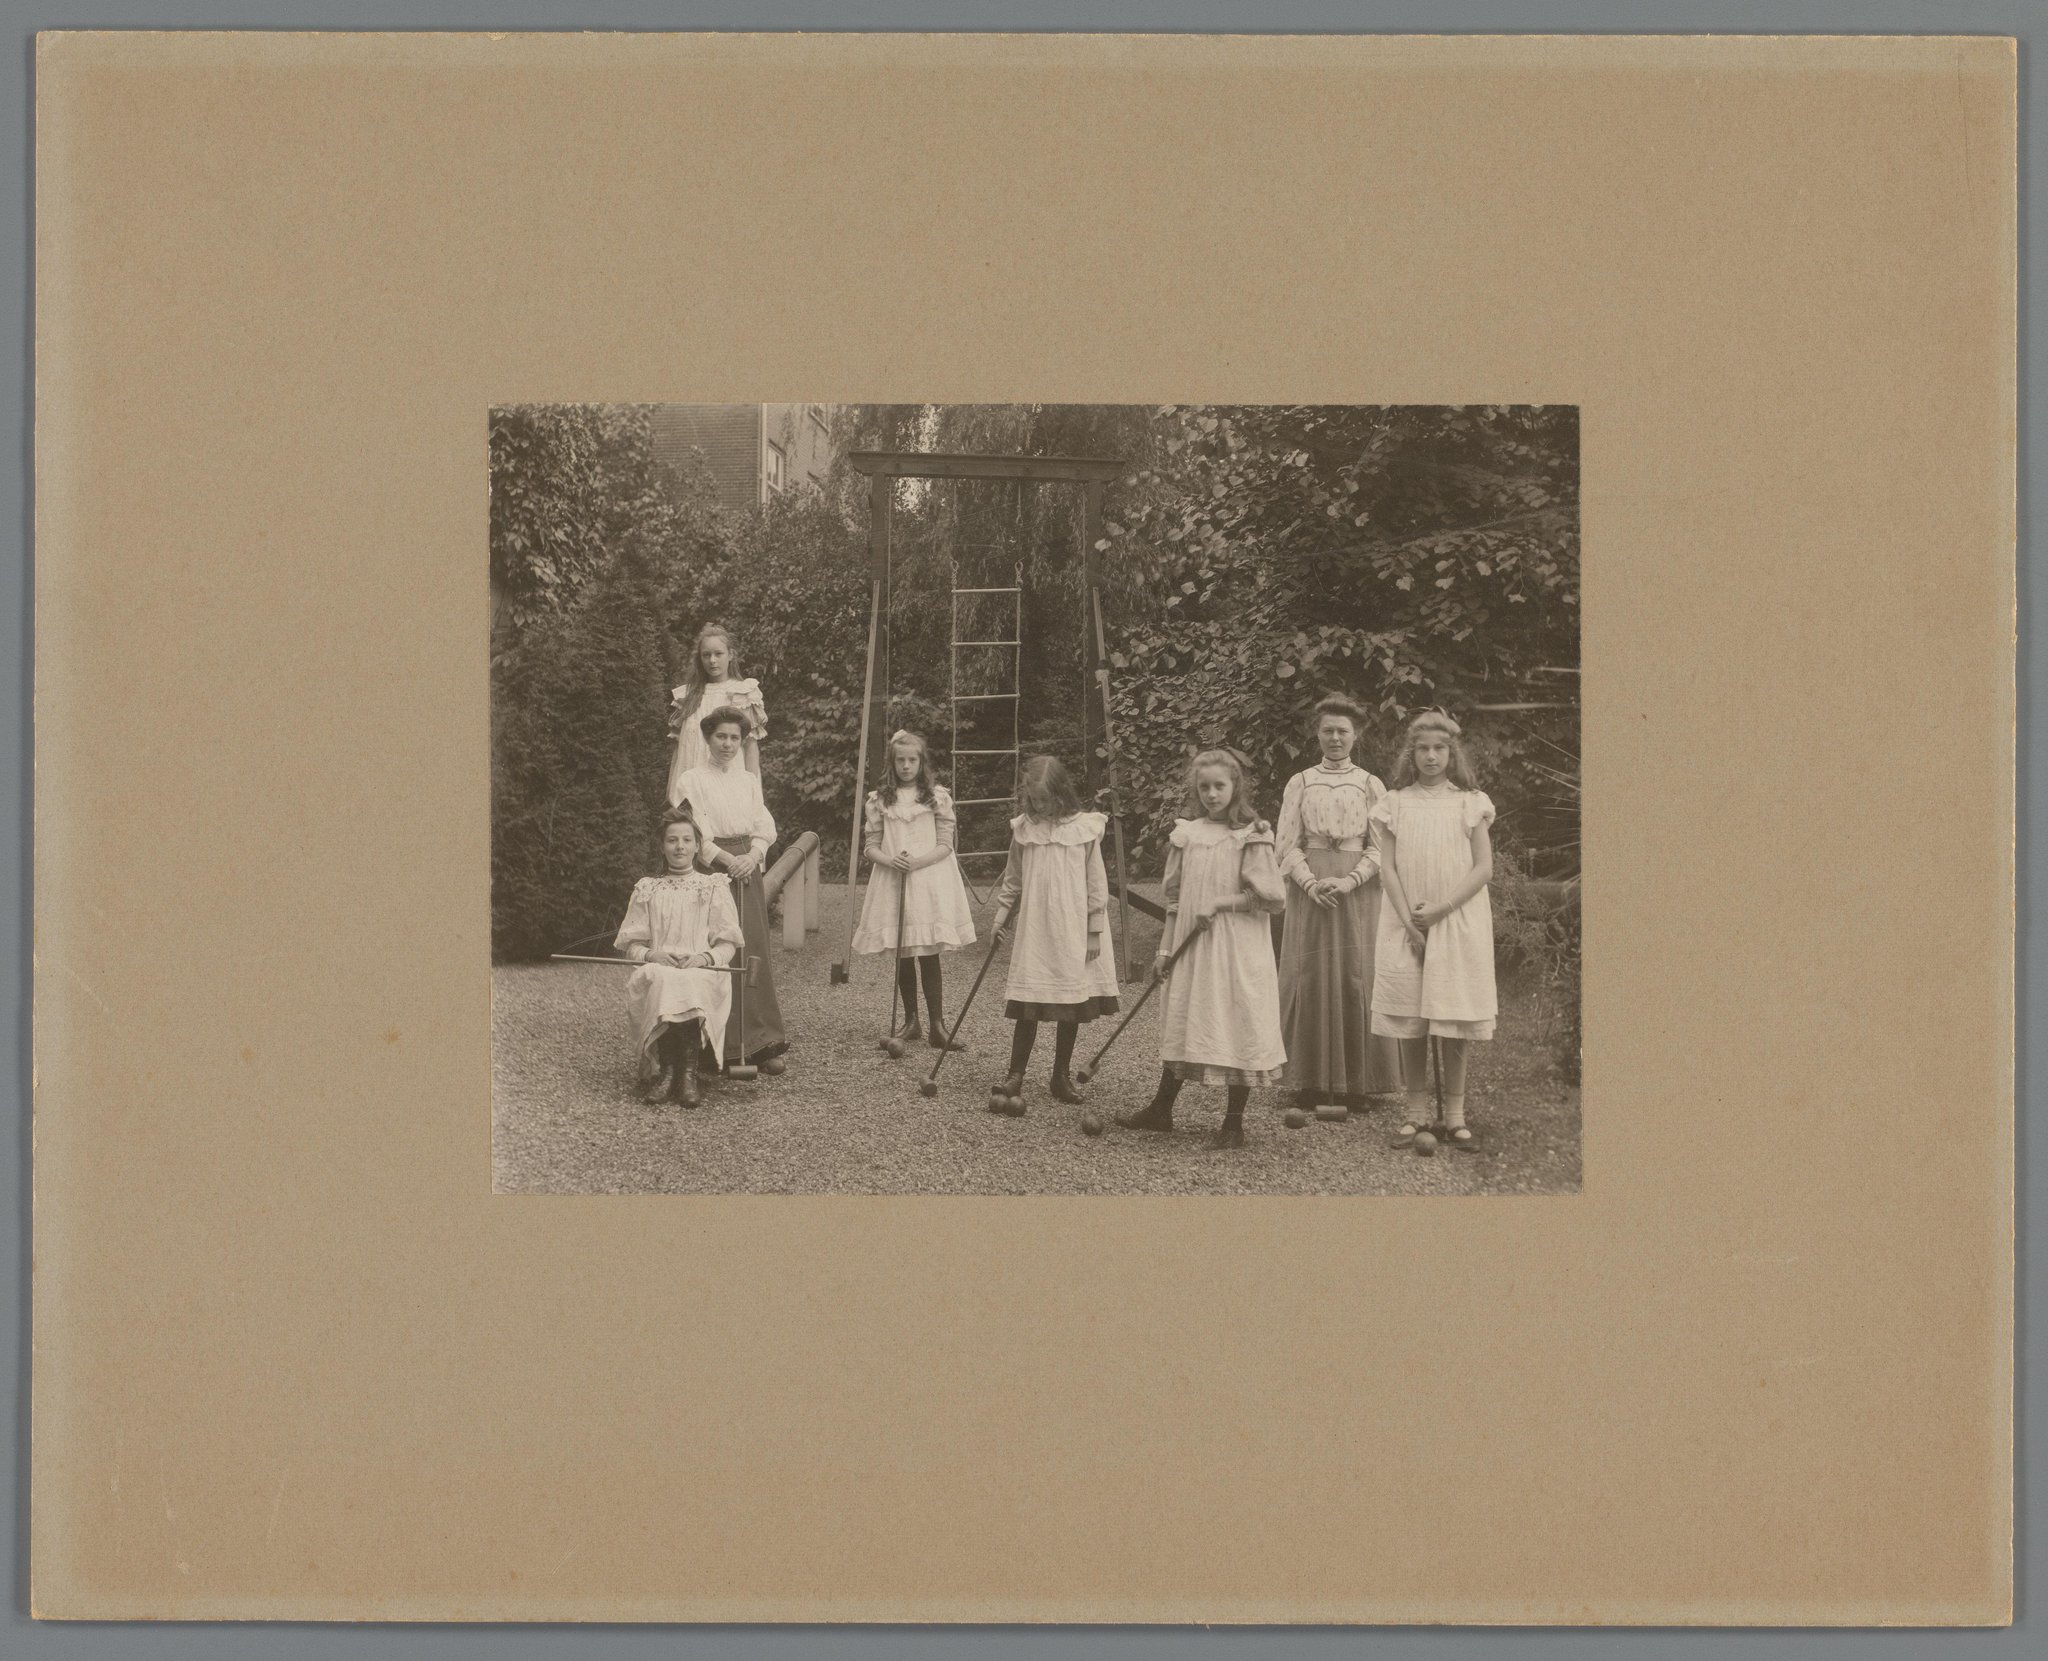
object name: photograph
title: Groepsportret van Johanna (Hans) de Jong met meisjes en vrouwen met croquet mallet in een tuin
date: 1905-1910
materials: paper, cardboard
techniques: gelatin silver print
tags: leiden, johanna petronella lambertina stokhuyzen-de jong (hans), historical persons - bb - woman, girl (child between toddler and youth), croquet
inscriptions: inscription: ‘1 3/8 J W 61’